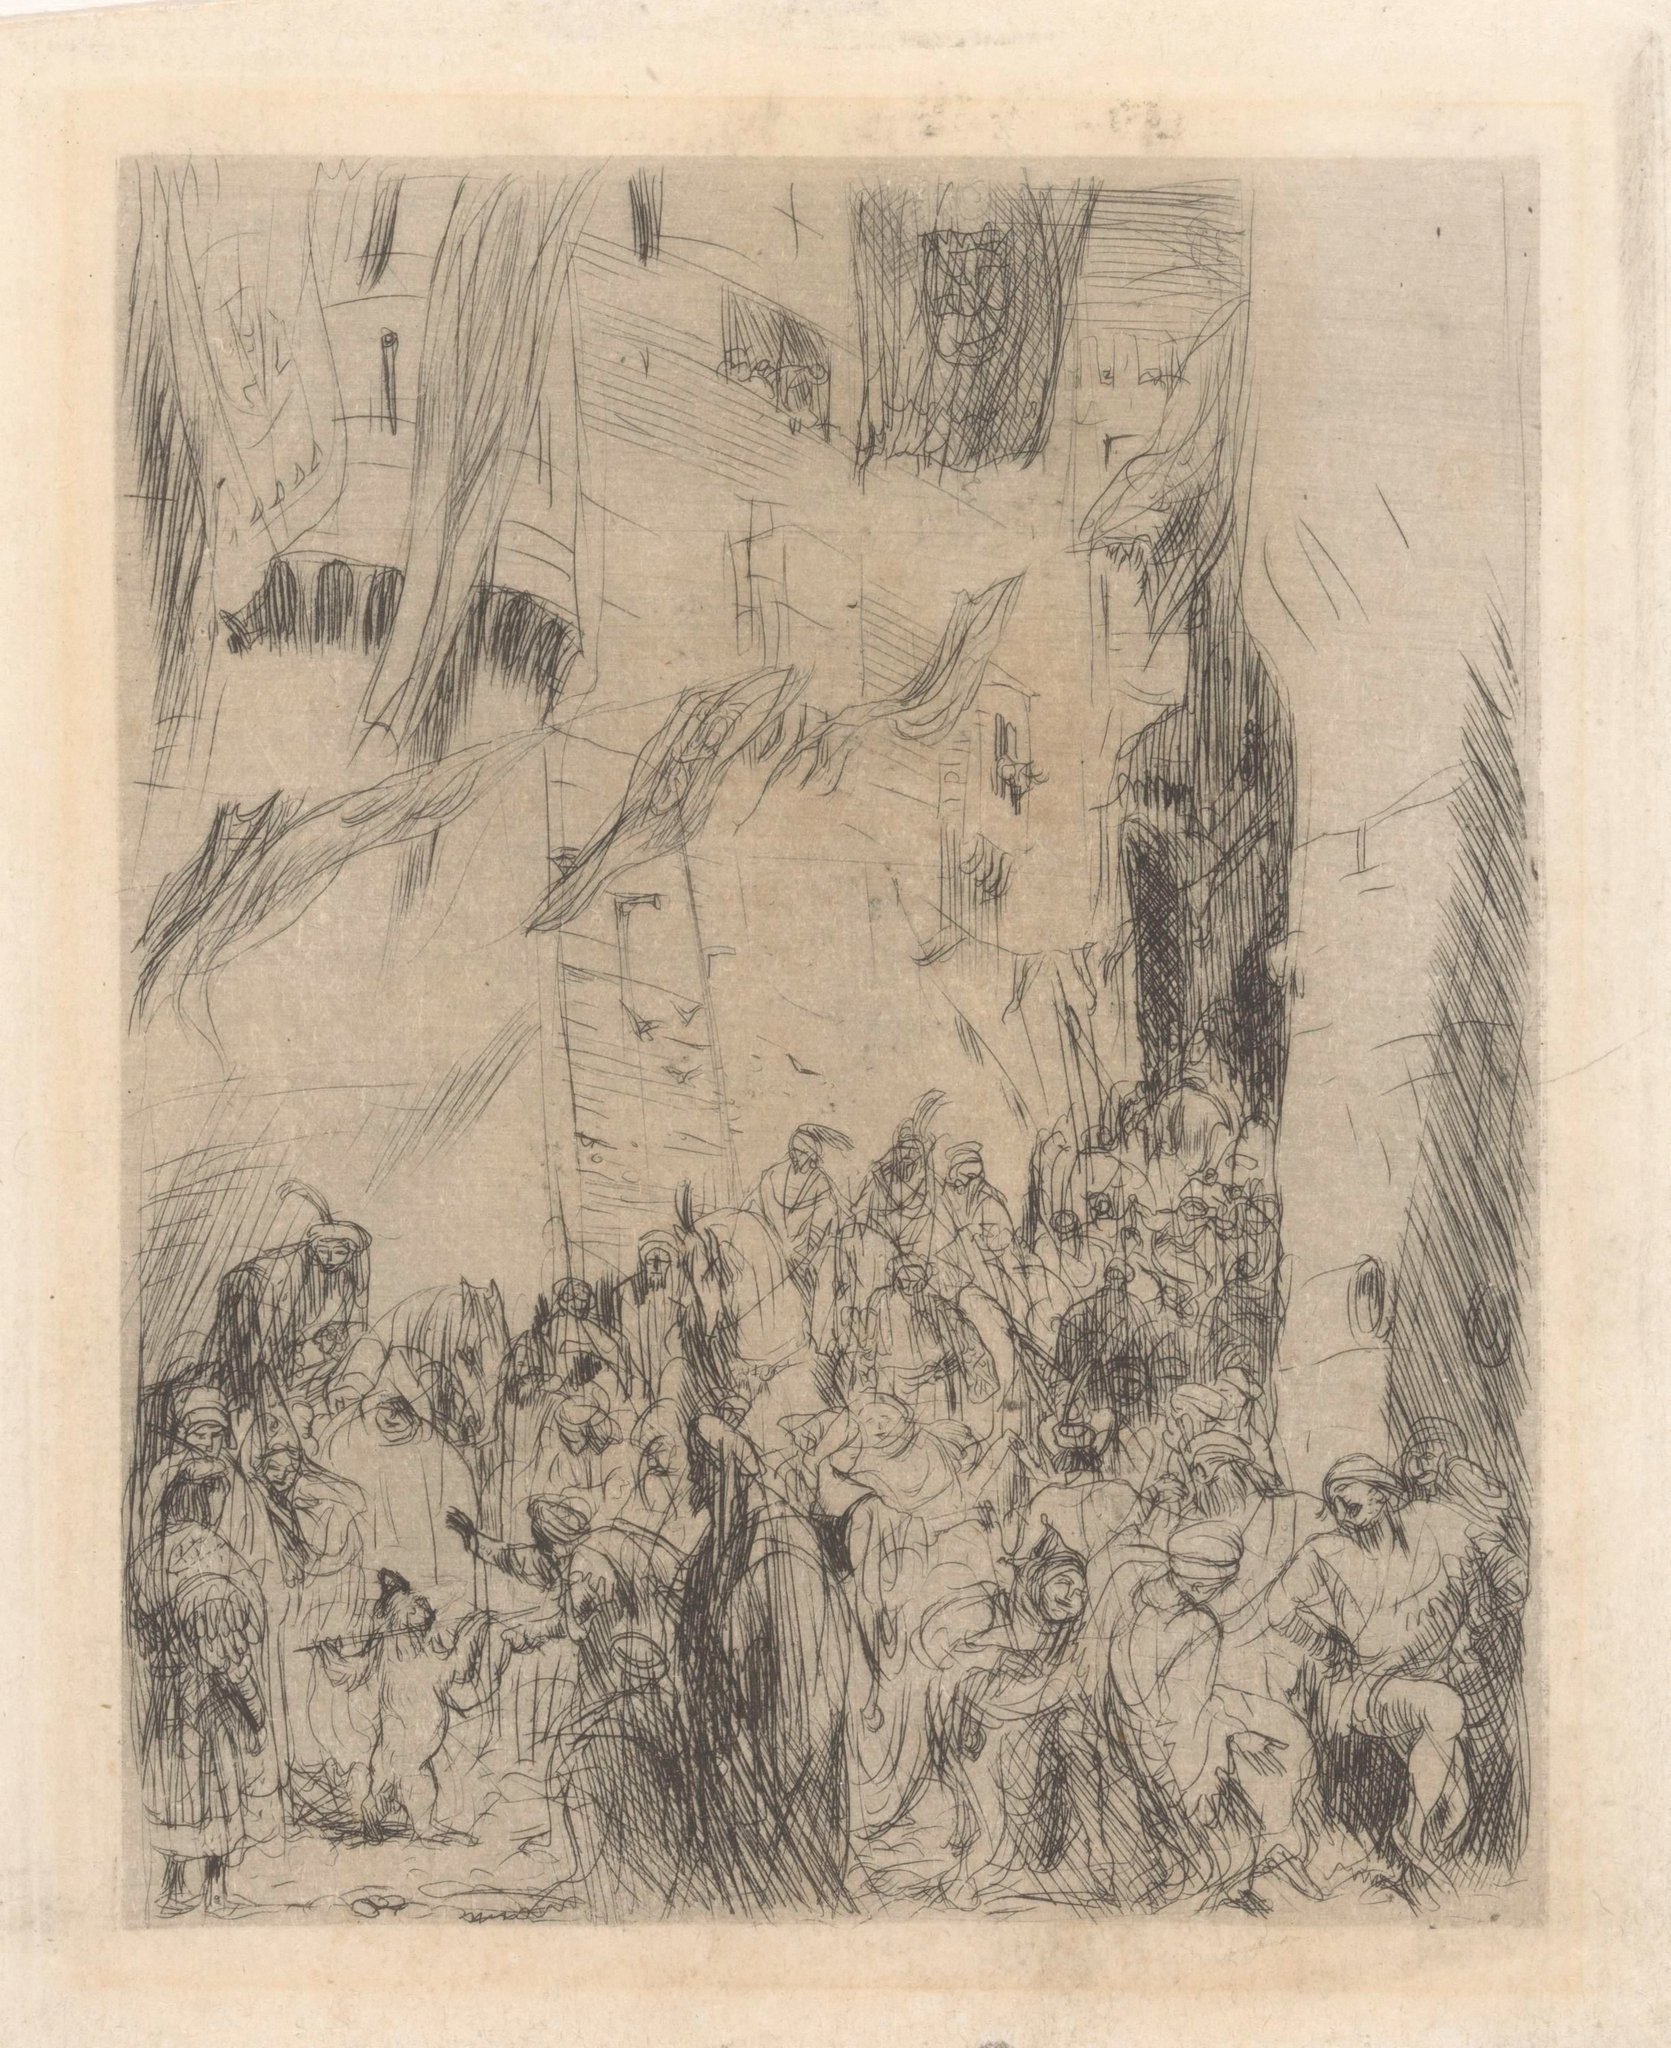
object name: print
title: Festival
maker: marius bauer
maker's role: draughtsman, print maker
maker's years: 1867-1932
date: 1897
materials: paper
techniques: etching, intaglio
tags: public festivities, group dancing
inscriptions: collector's mark: Lugt 2228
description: Bauer vervaardigde deze ets voor zijn prentenserie naar het Roemeense sprookje 'La jeunesse inaltérable et la vie éternelle', maar nam de ets er uiteindelijk niet in op.